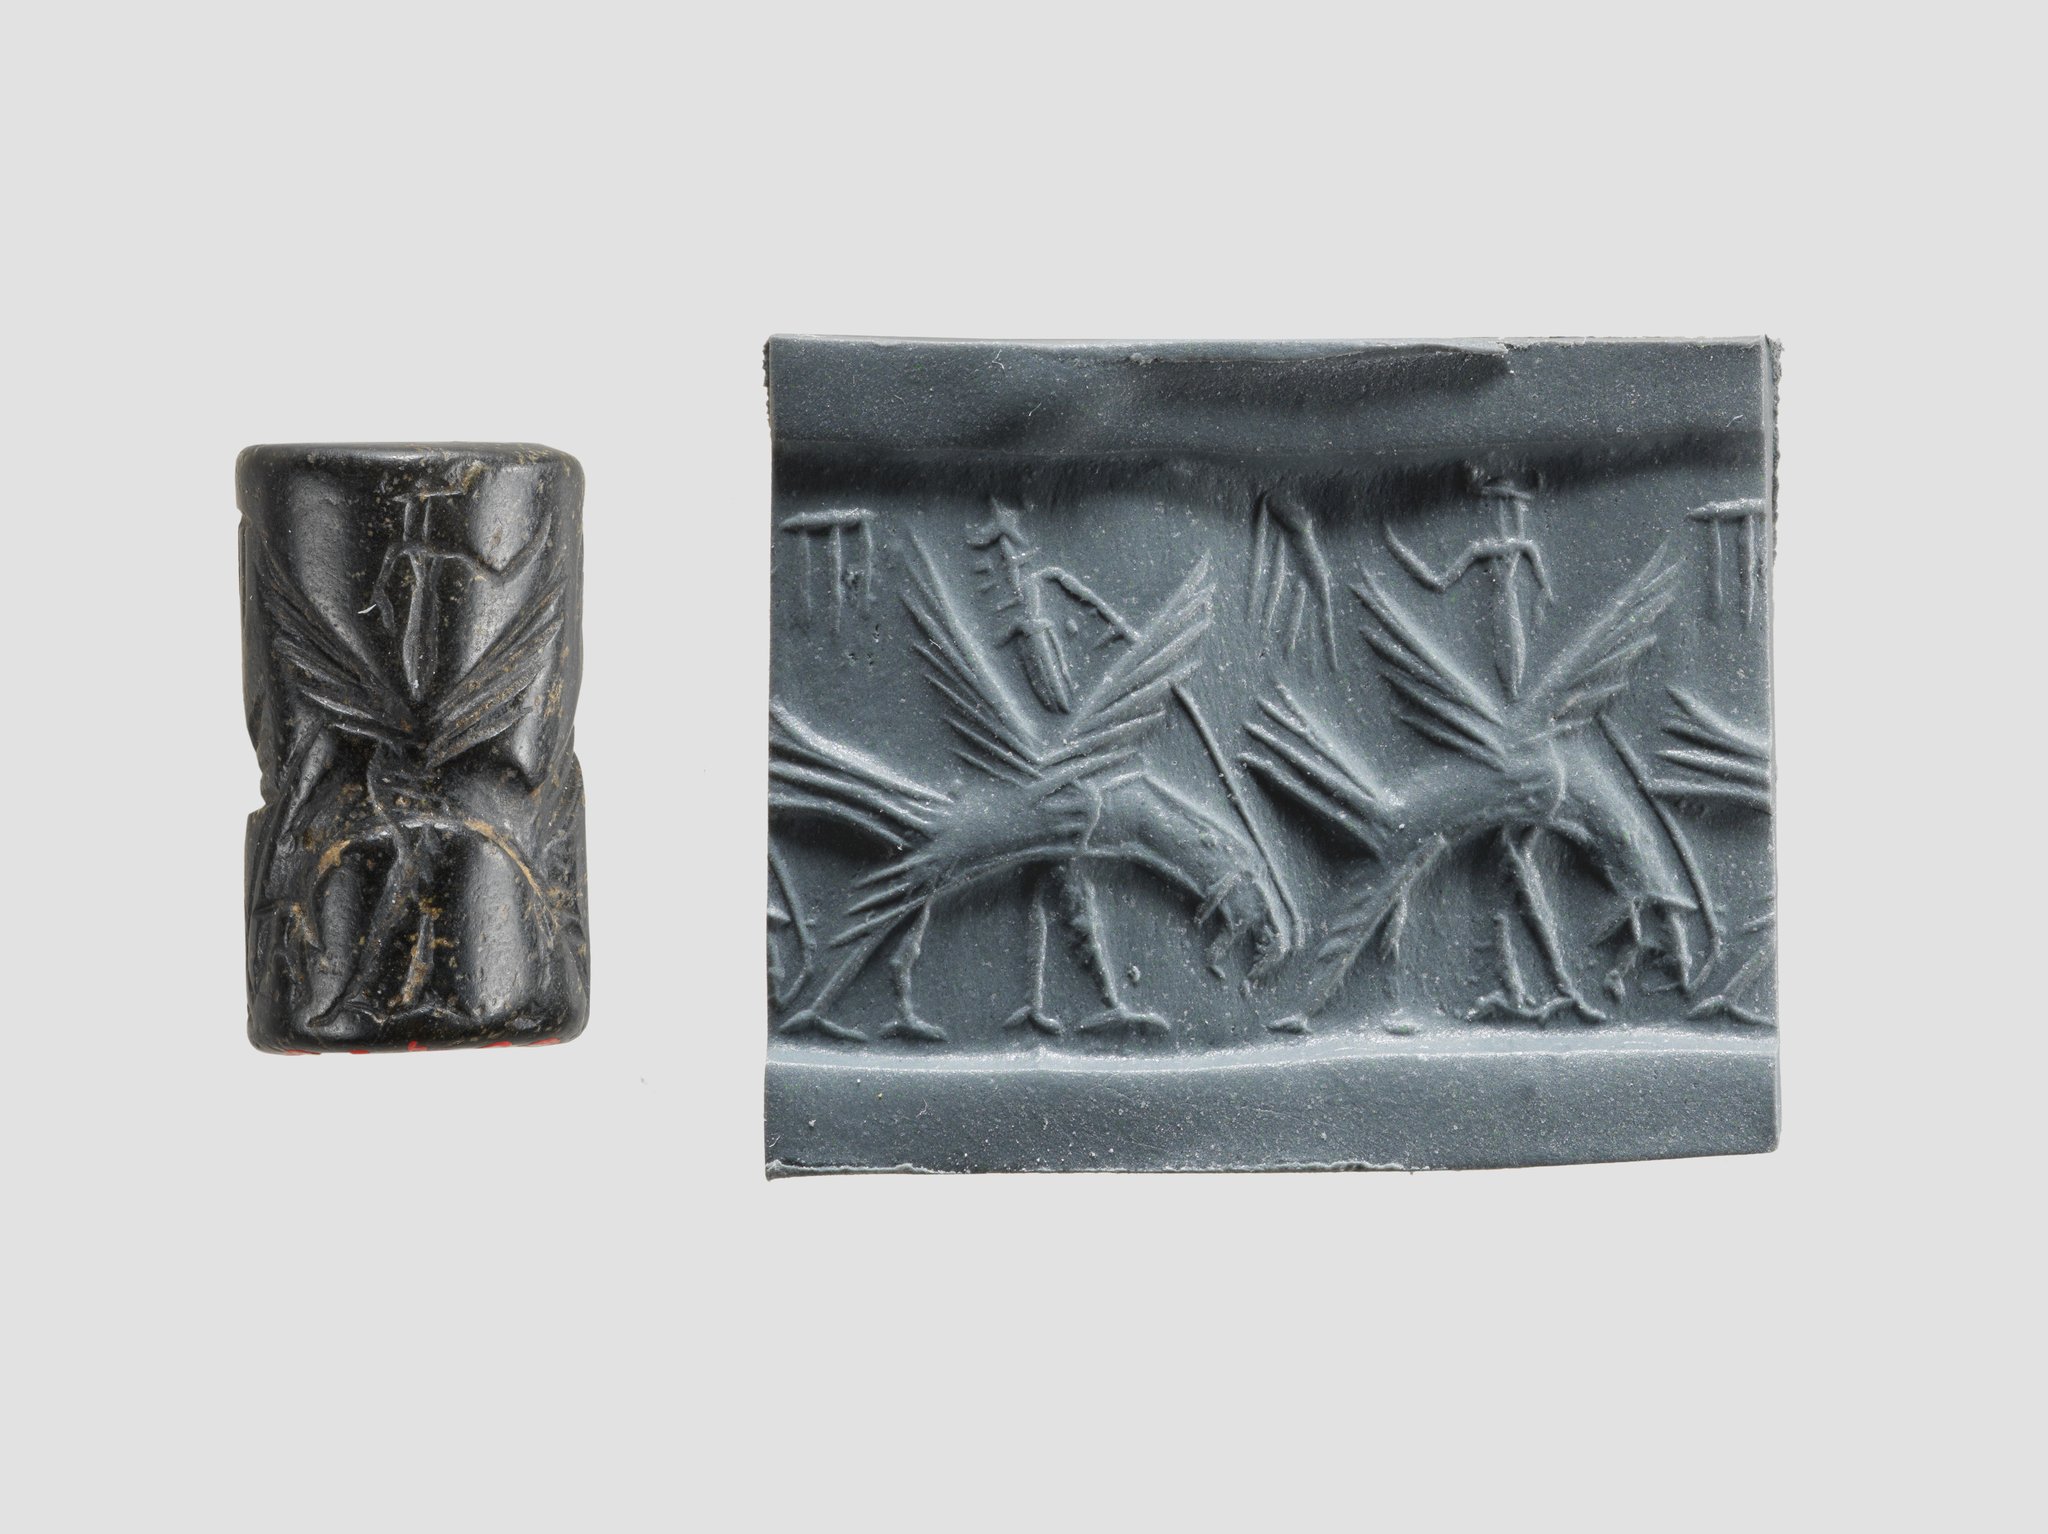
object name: cylinder seal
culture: akkadian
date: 2350-2150 BCE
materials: stone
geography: mesopotamia